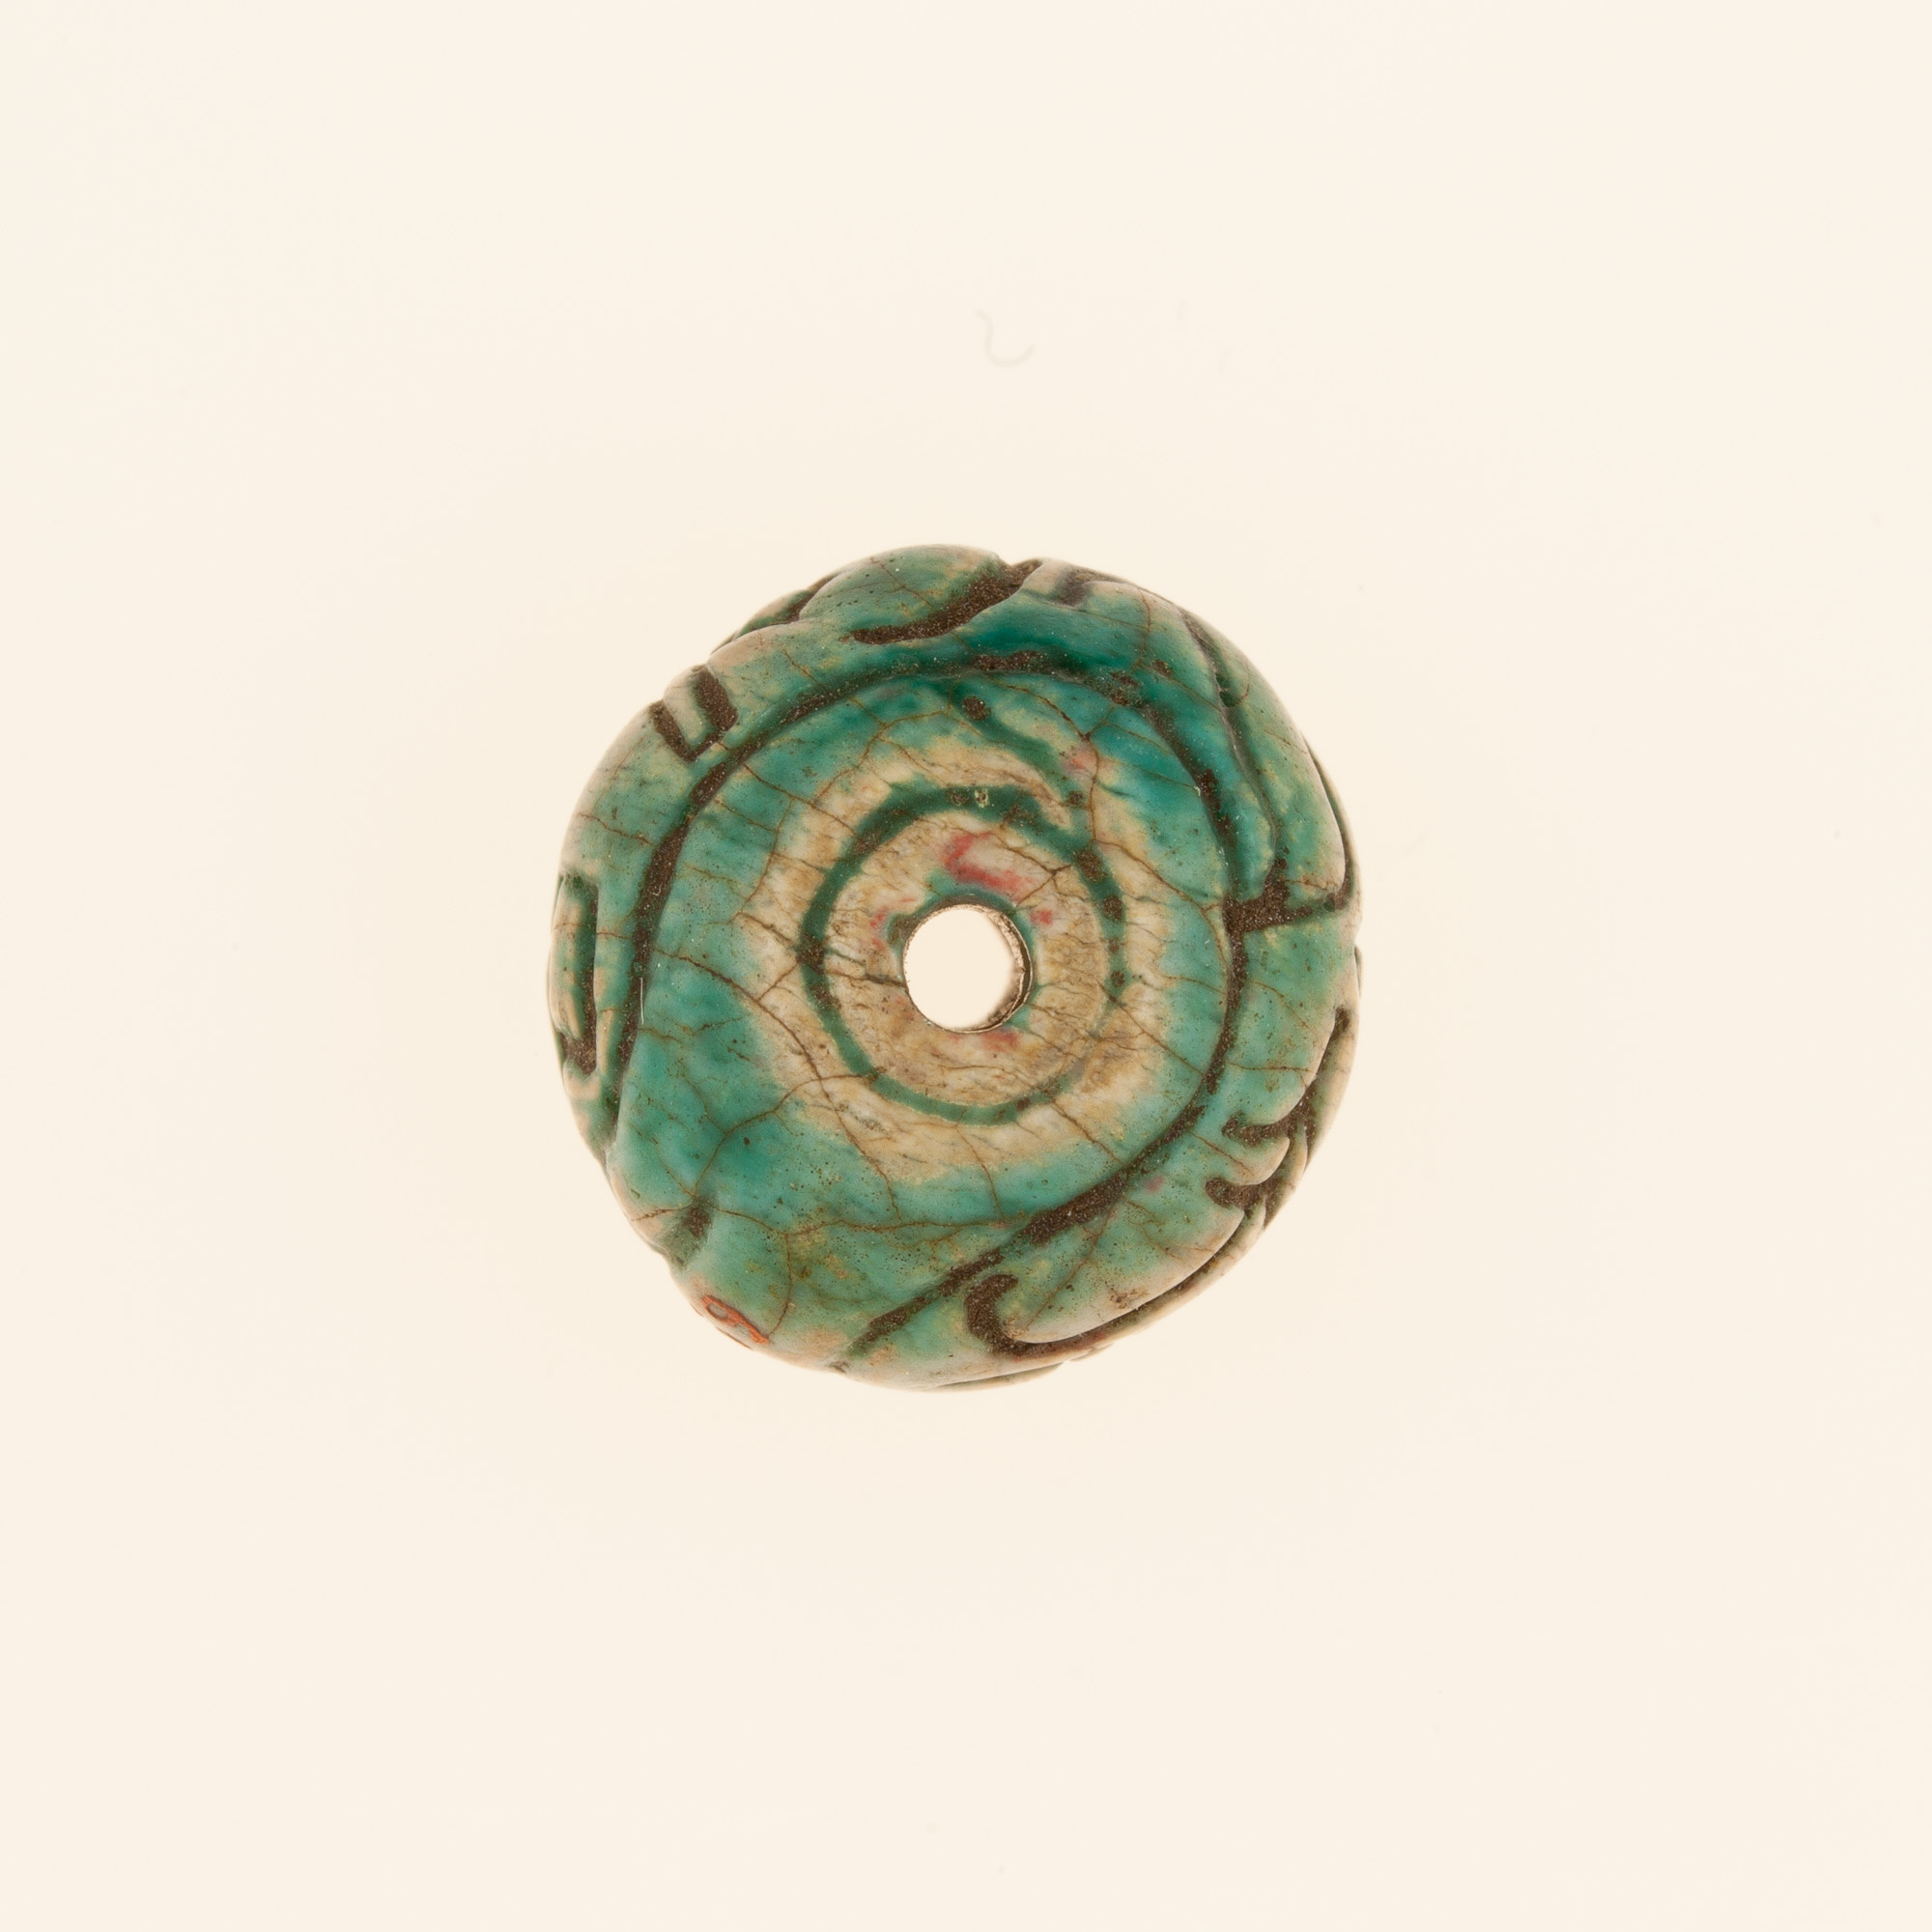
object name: bead, ahhotep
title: Bead Naming Queen Ahhotep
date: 1550-1525 BCE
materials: stone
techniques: glazing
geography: egypt